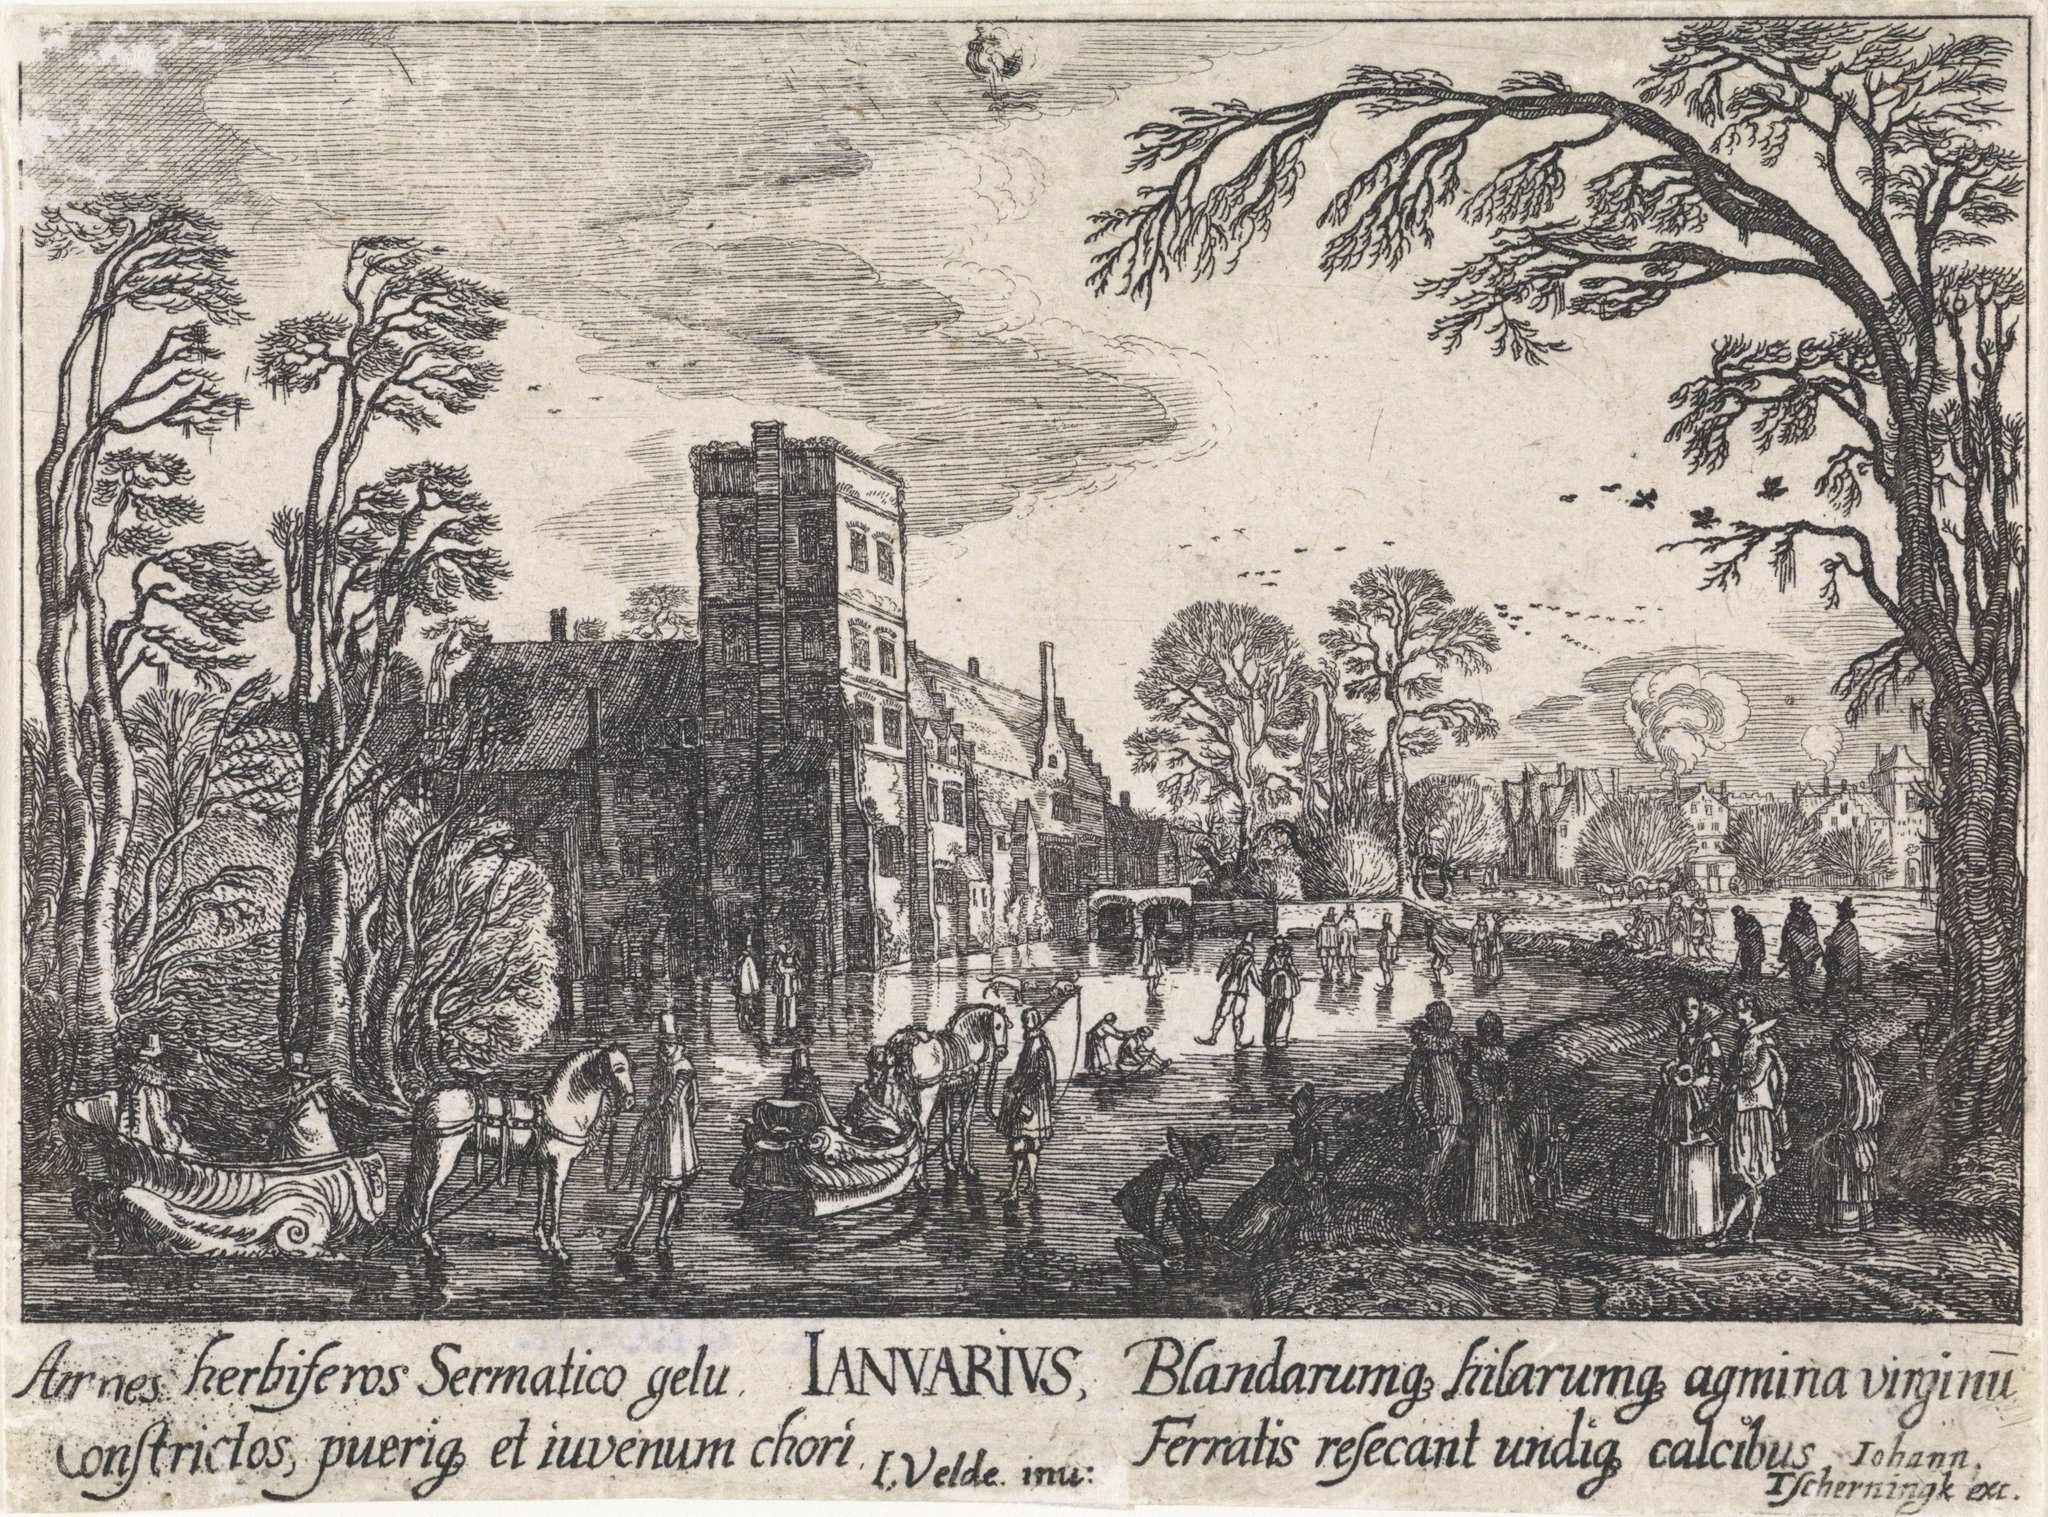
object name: print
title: Ianuarius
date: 1684-1729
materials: paper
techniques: etching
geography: germany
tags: winter sports, january and its 'labours', aquarius (zodiacal sign of january), landscape symbolizing january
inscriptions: collector's mark: Lugt 2228, collector's mark: Lugt 2760, collector's mark: Lugt 384, collector's mark: Lugt 3790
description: Landschap met schaatsenrijders en door paarden getrokken sledes op het ijs bij het hof in Den Haag, voorstellende de maand januari. Bovenaan het bij deze maand behorende sterrenbeeld: waterman. Eerste prent uit een serie van twaalf.